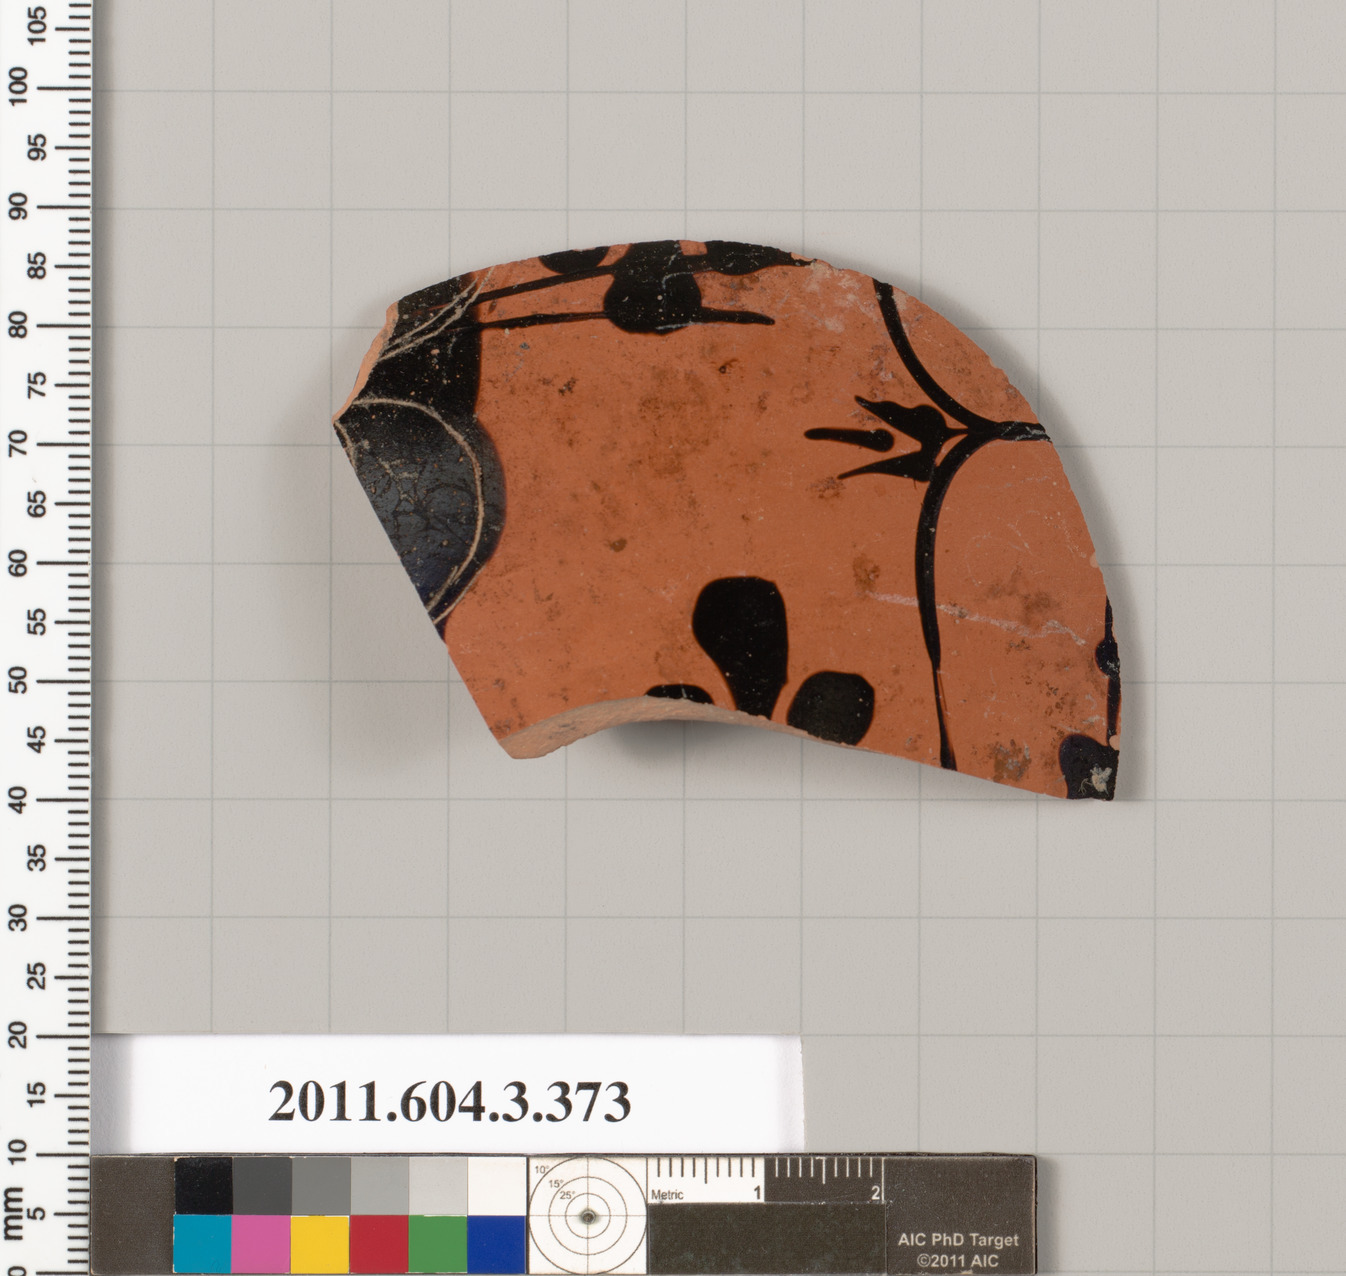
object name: neck amphora fragment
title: Terracotta fragment of a neck-amphora (jar)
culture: greek, attic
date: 530-520 BCE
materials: terracotta